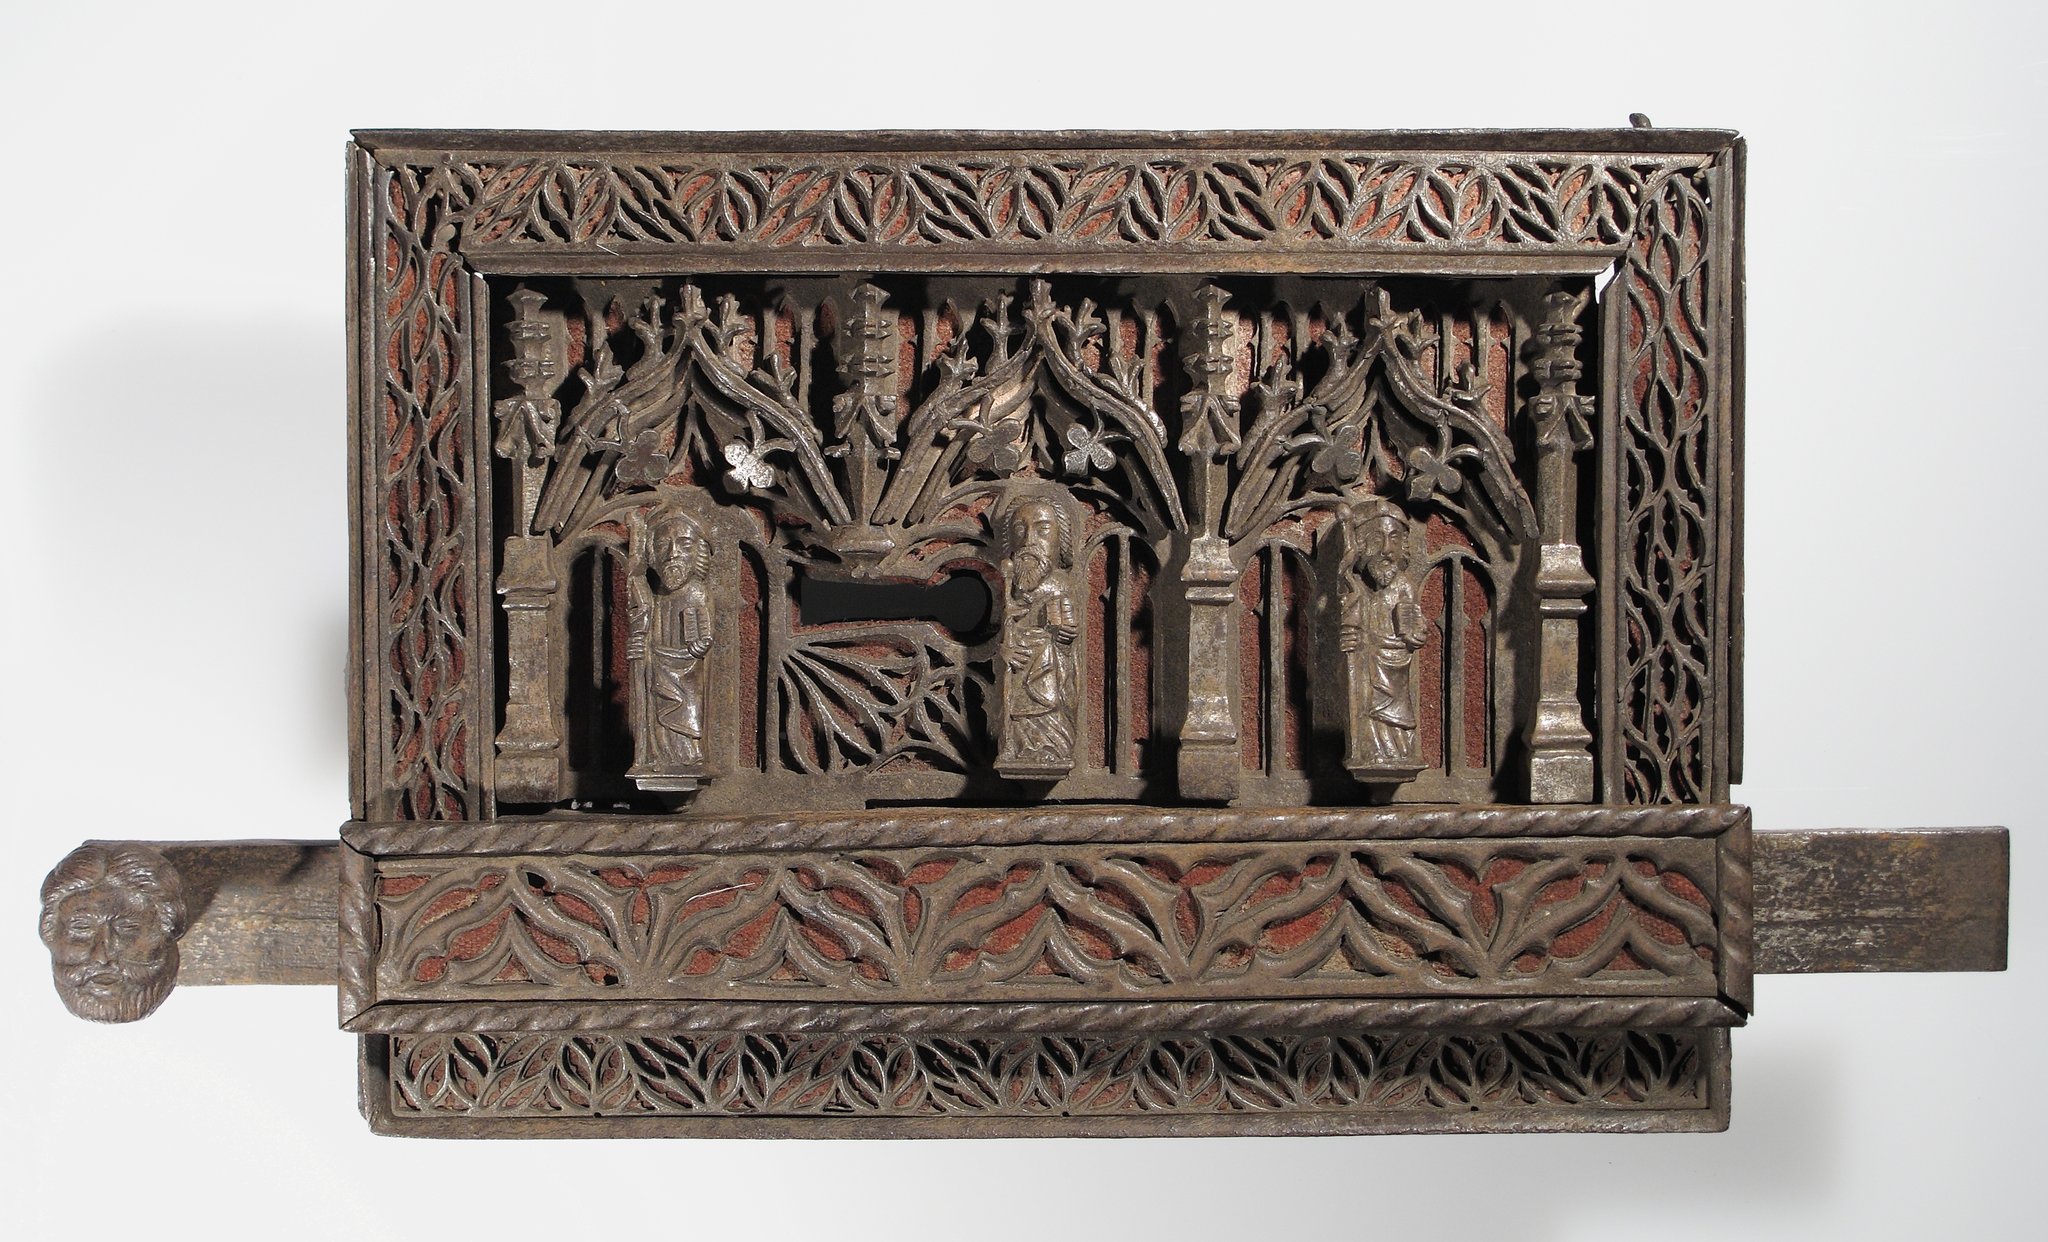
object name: lock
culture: european or french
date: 1401-1600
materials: iron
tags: men